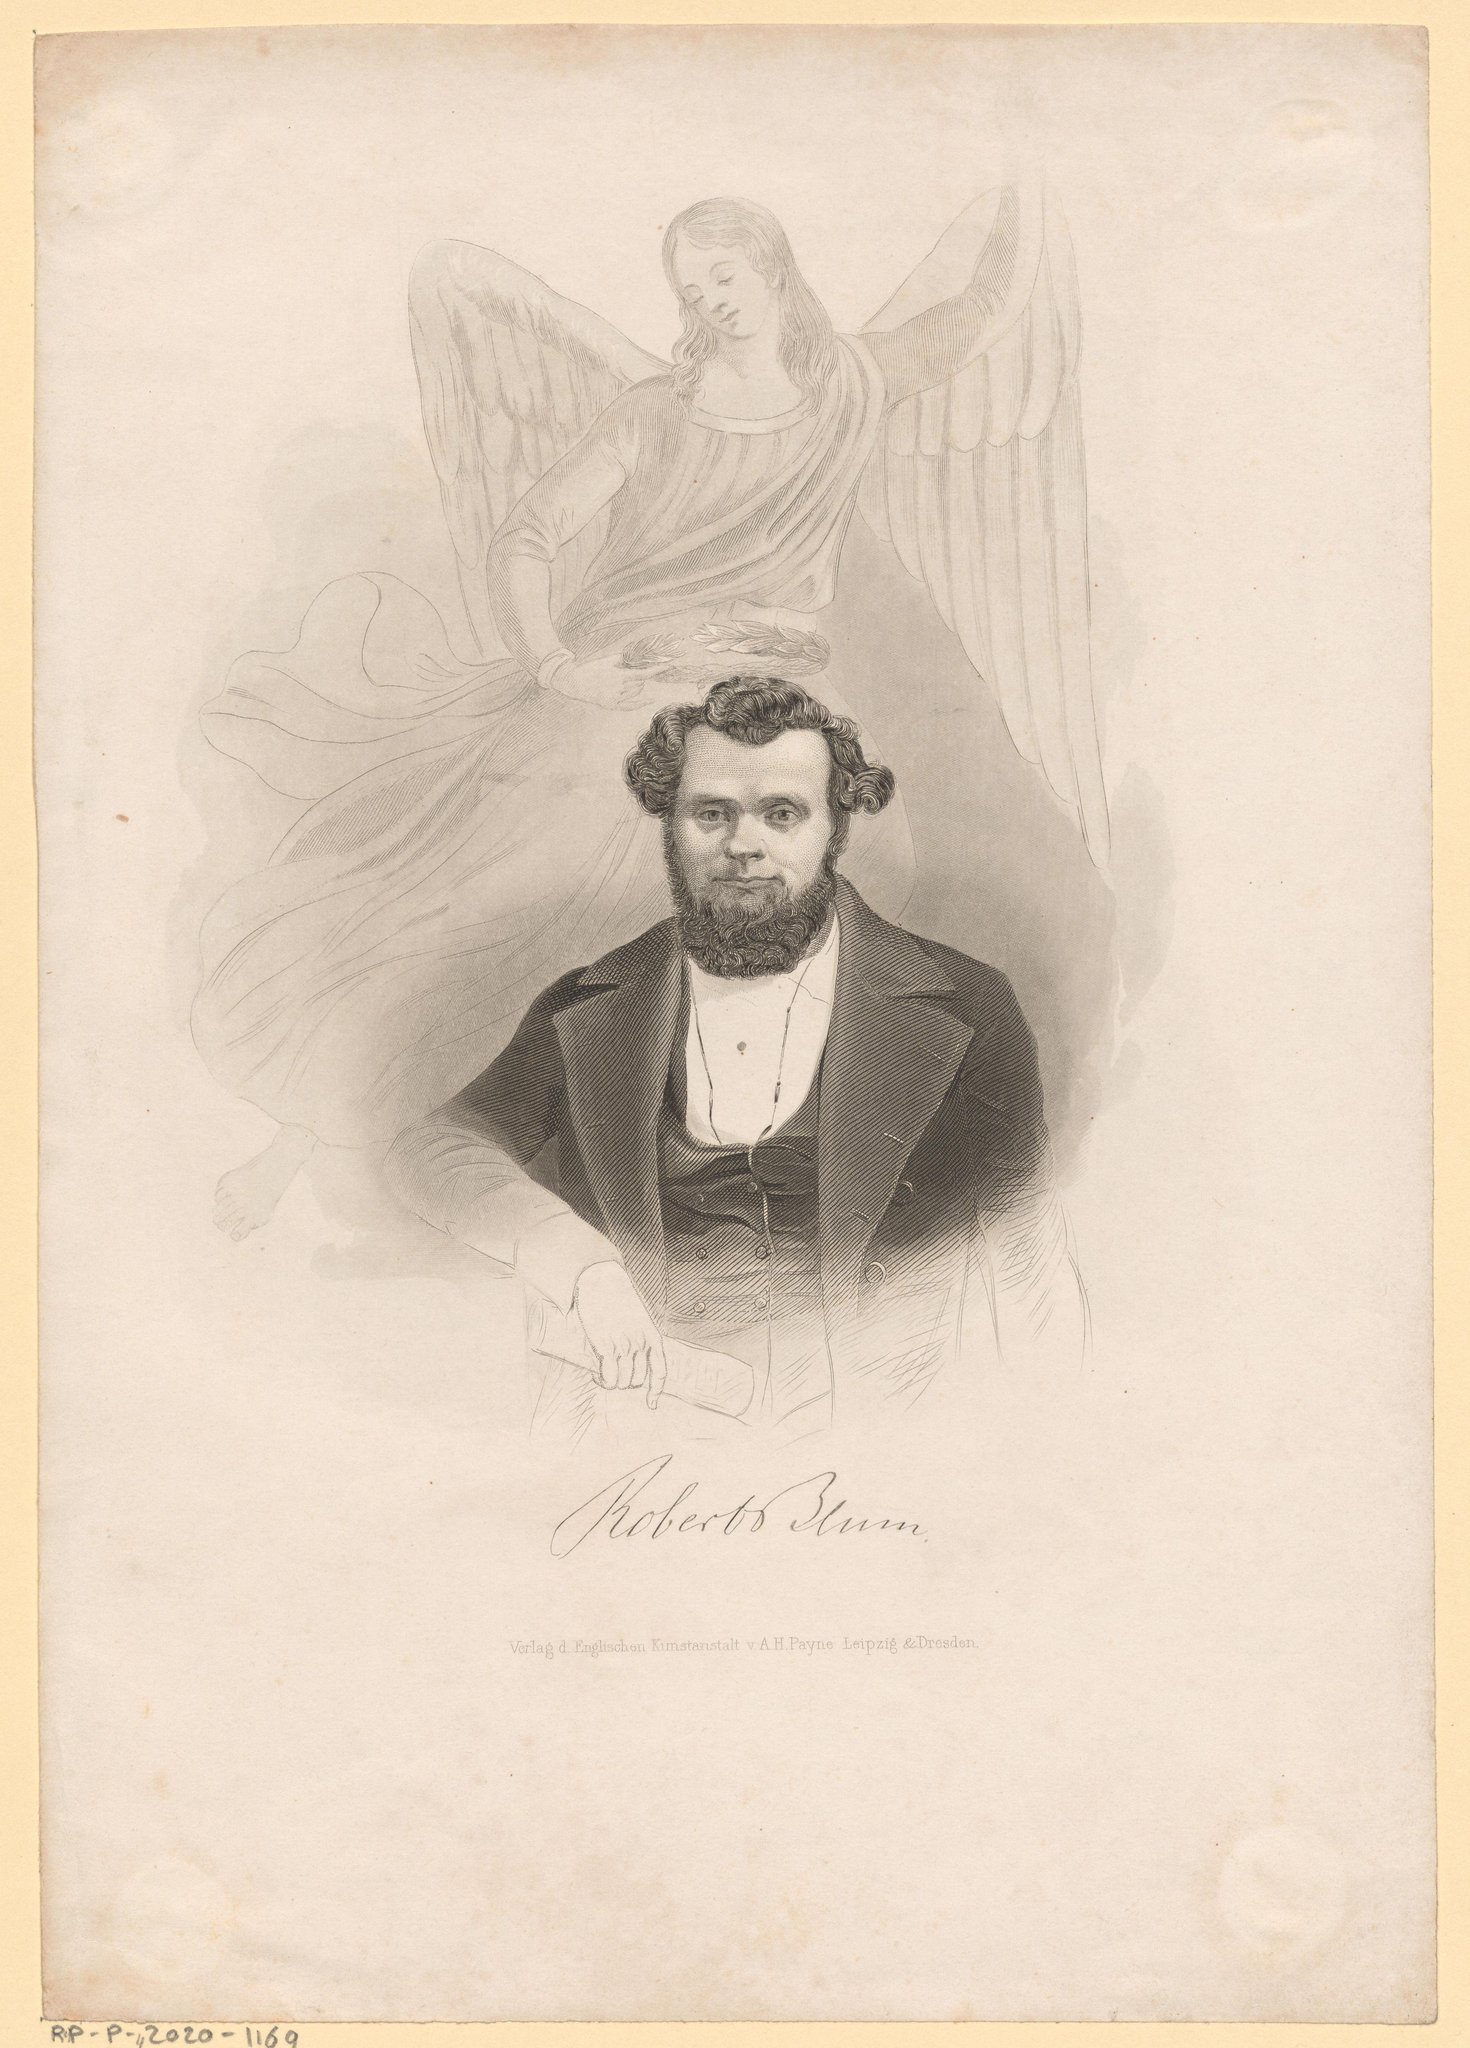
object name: print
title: Portret van Robert Blum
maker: Anonymous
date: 1845-1880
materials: paper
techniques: etching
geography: dresden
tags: historical persons, politician, e.g. party leader, crowning with laurel